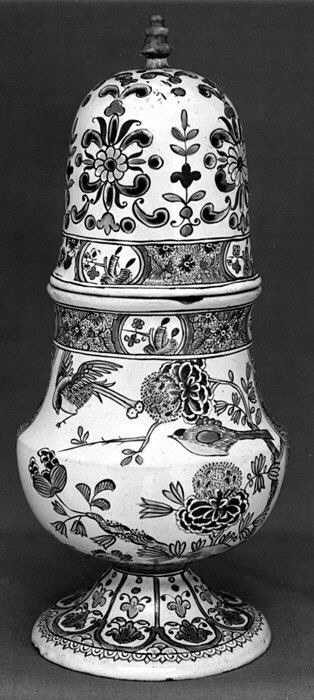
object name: sugar caster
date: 1700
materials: earthenware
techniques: glazing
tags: birds,flowers